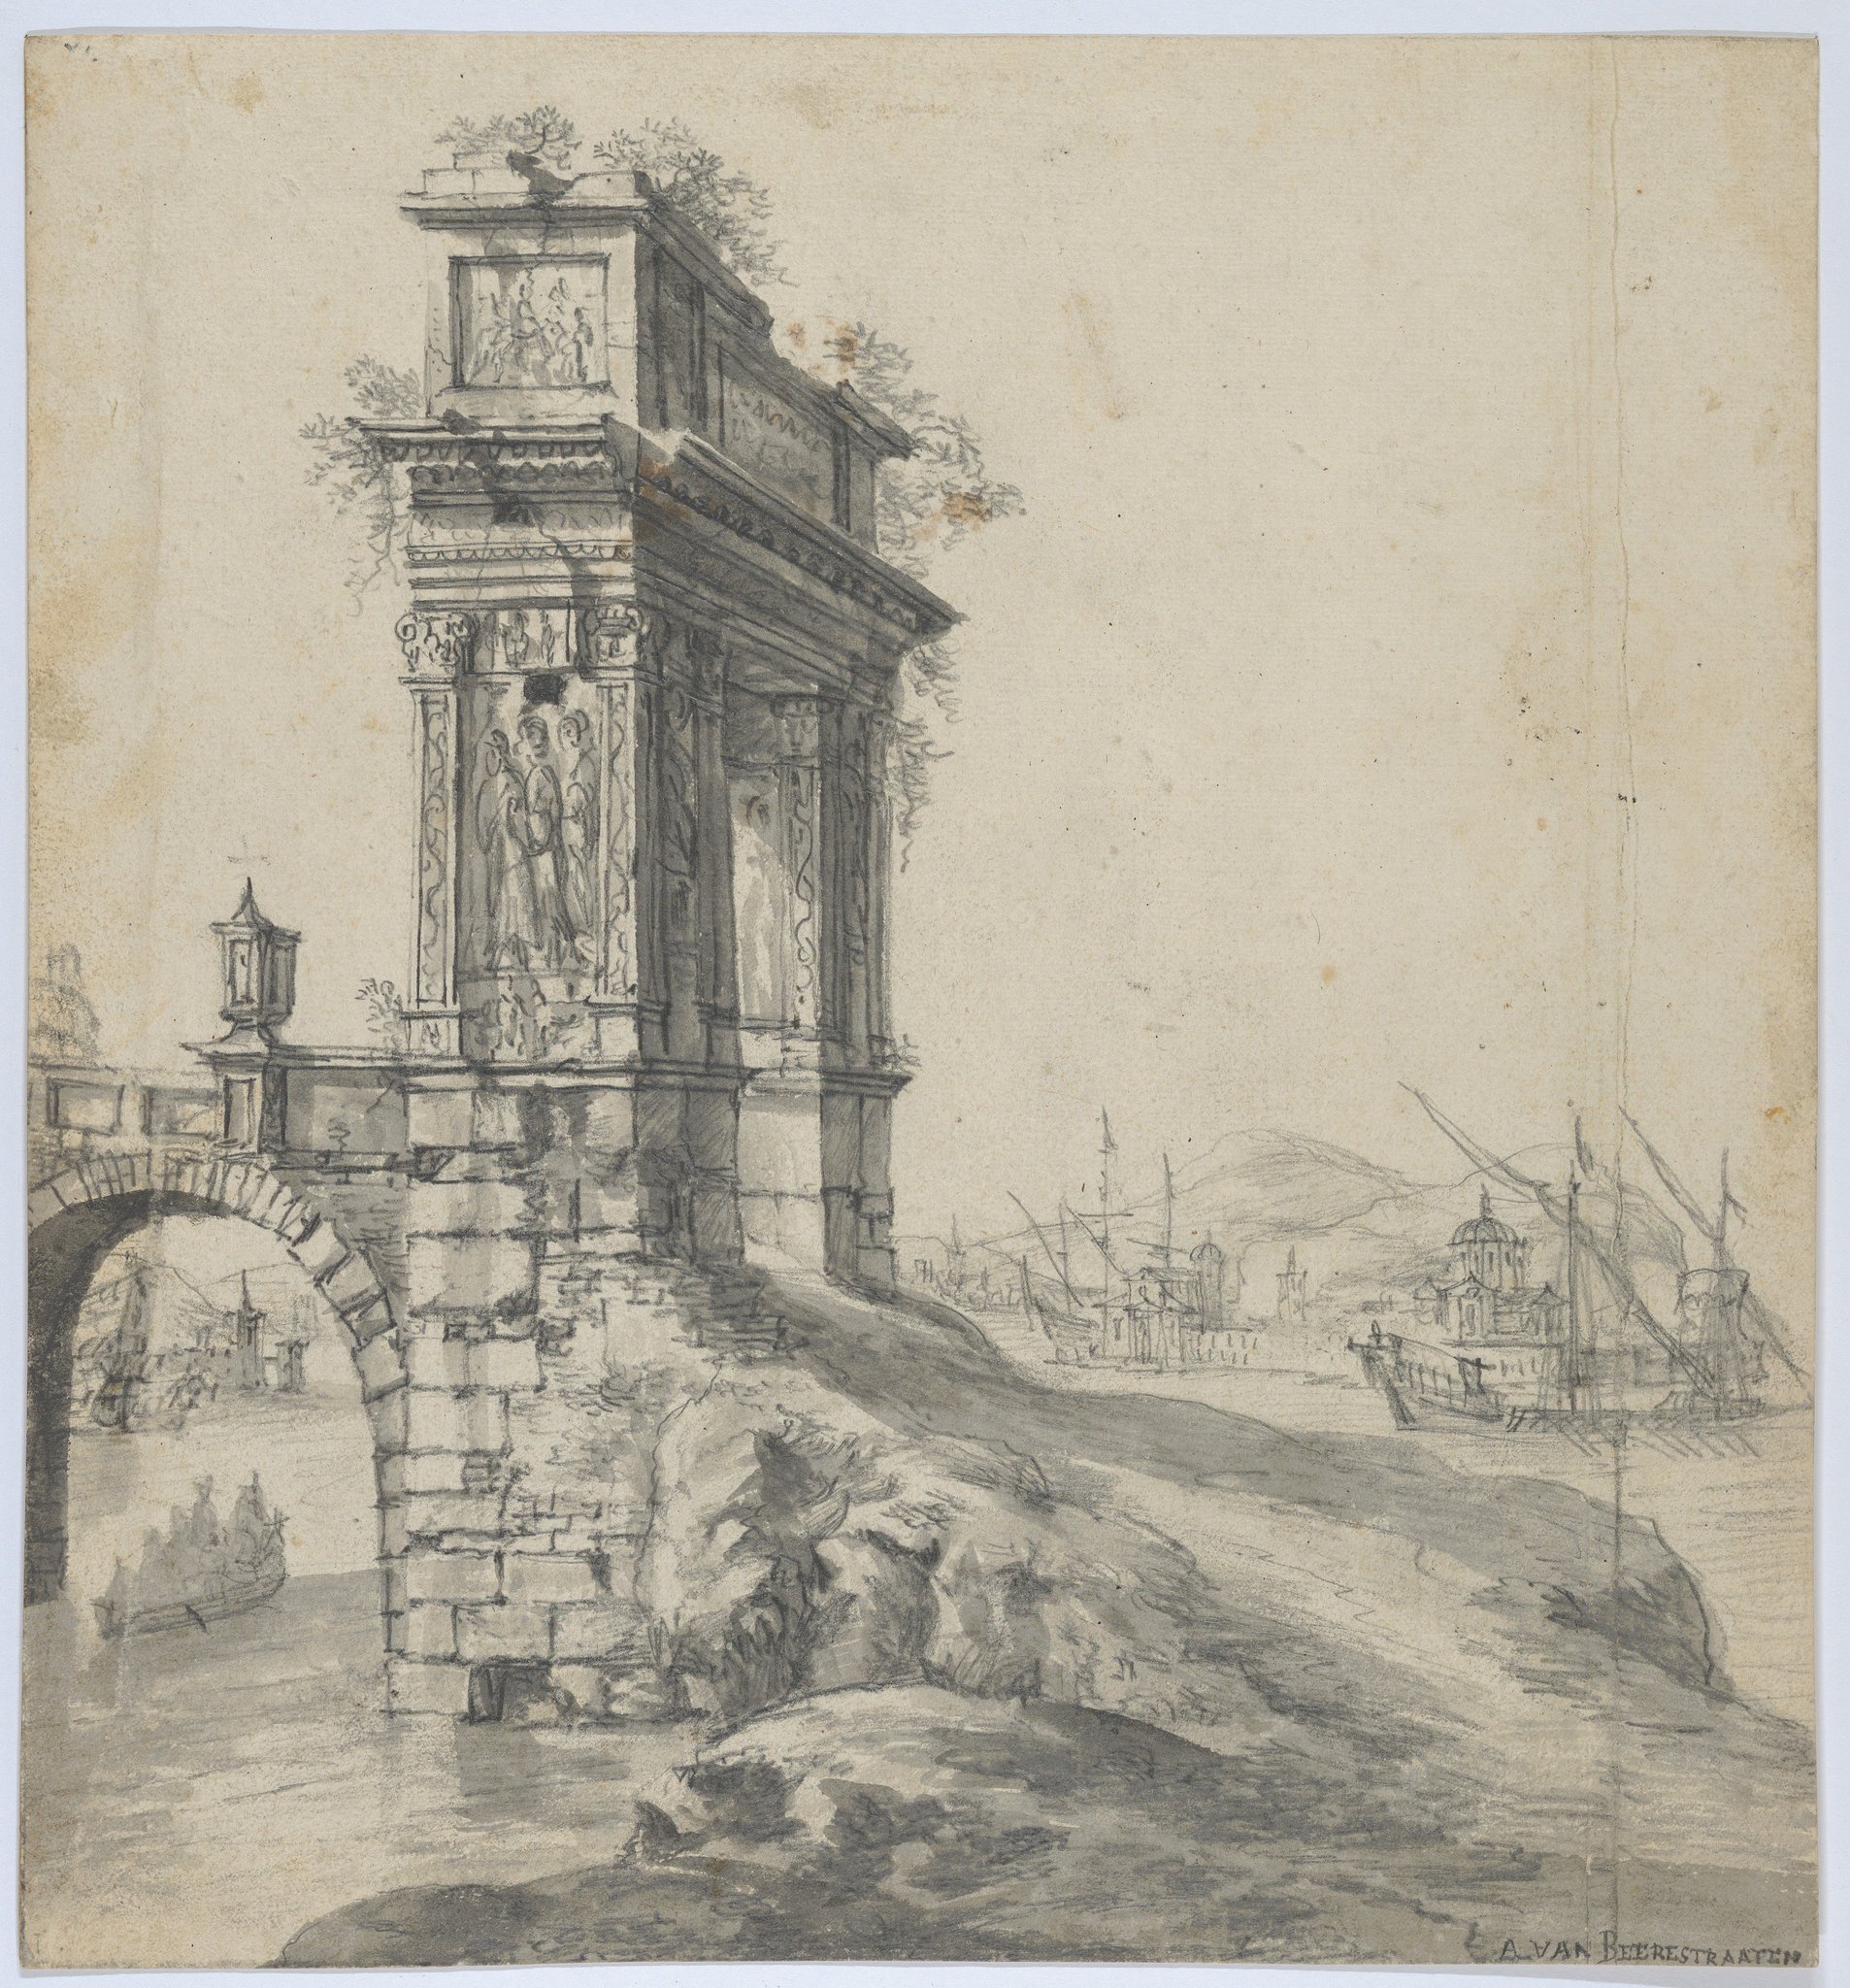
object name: drawing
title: Capriccio of a Bridge with the Arcus Argentariorum by a Mediterranean Harbor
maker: johannes abrahamsz beerstraten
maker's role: artist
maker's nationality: dutch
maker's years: 1622-1666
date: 1634-1666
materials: chalk, graphite, ink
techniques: brush, wash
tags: arches,bridges,boats